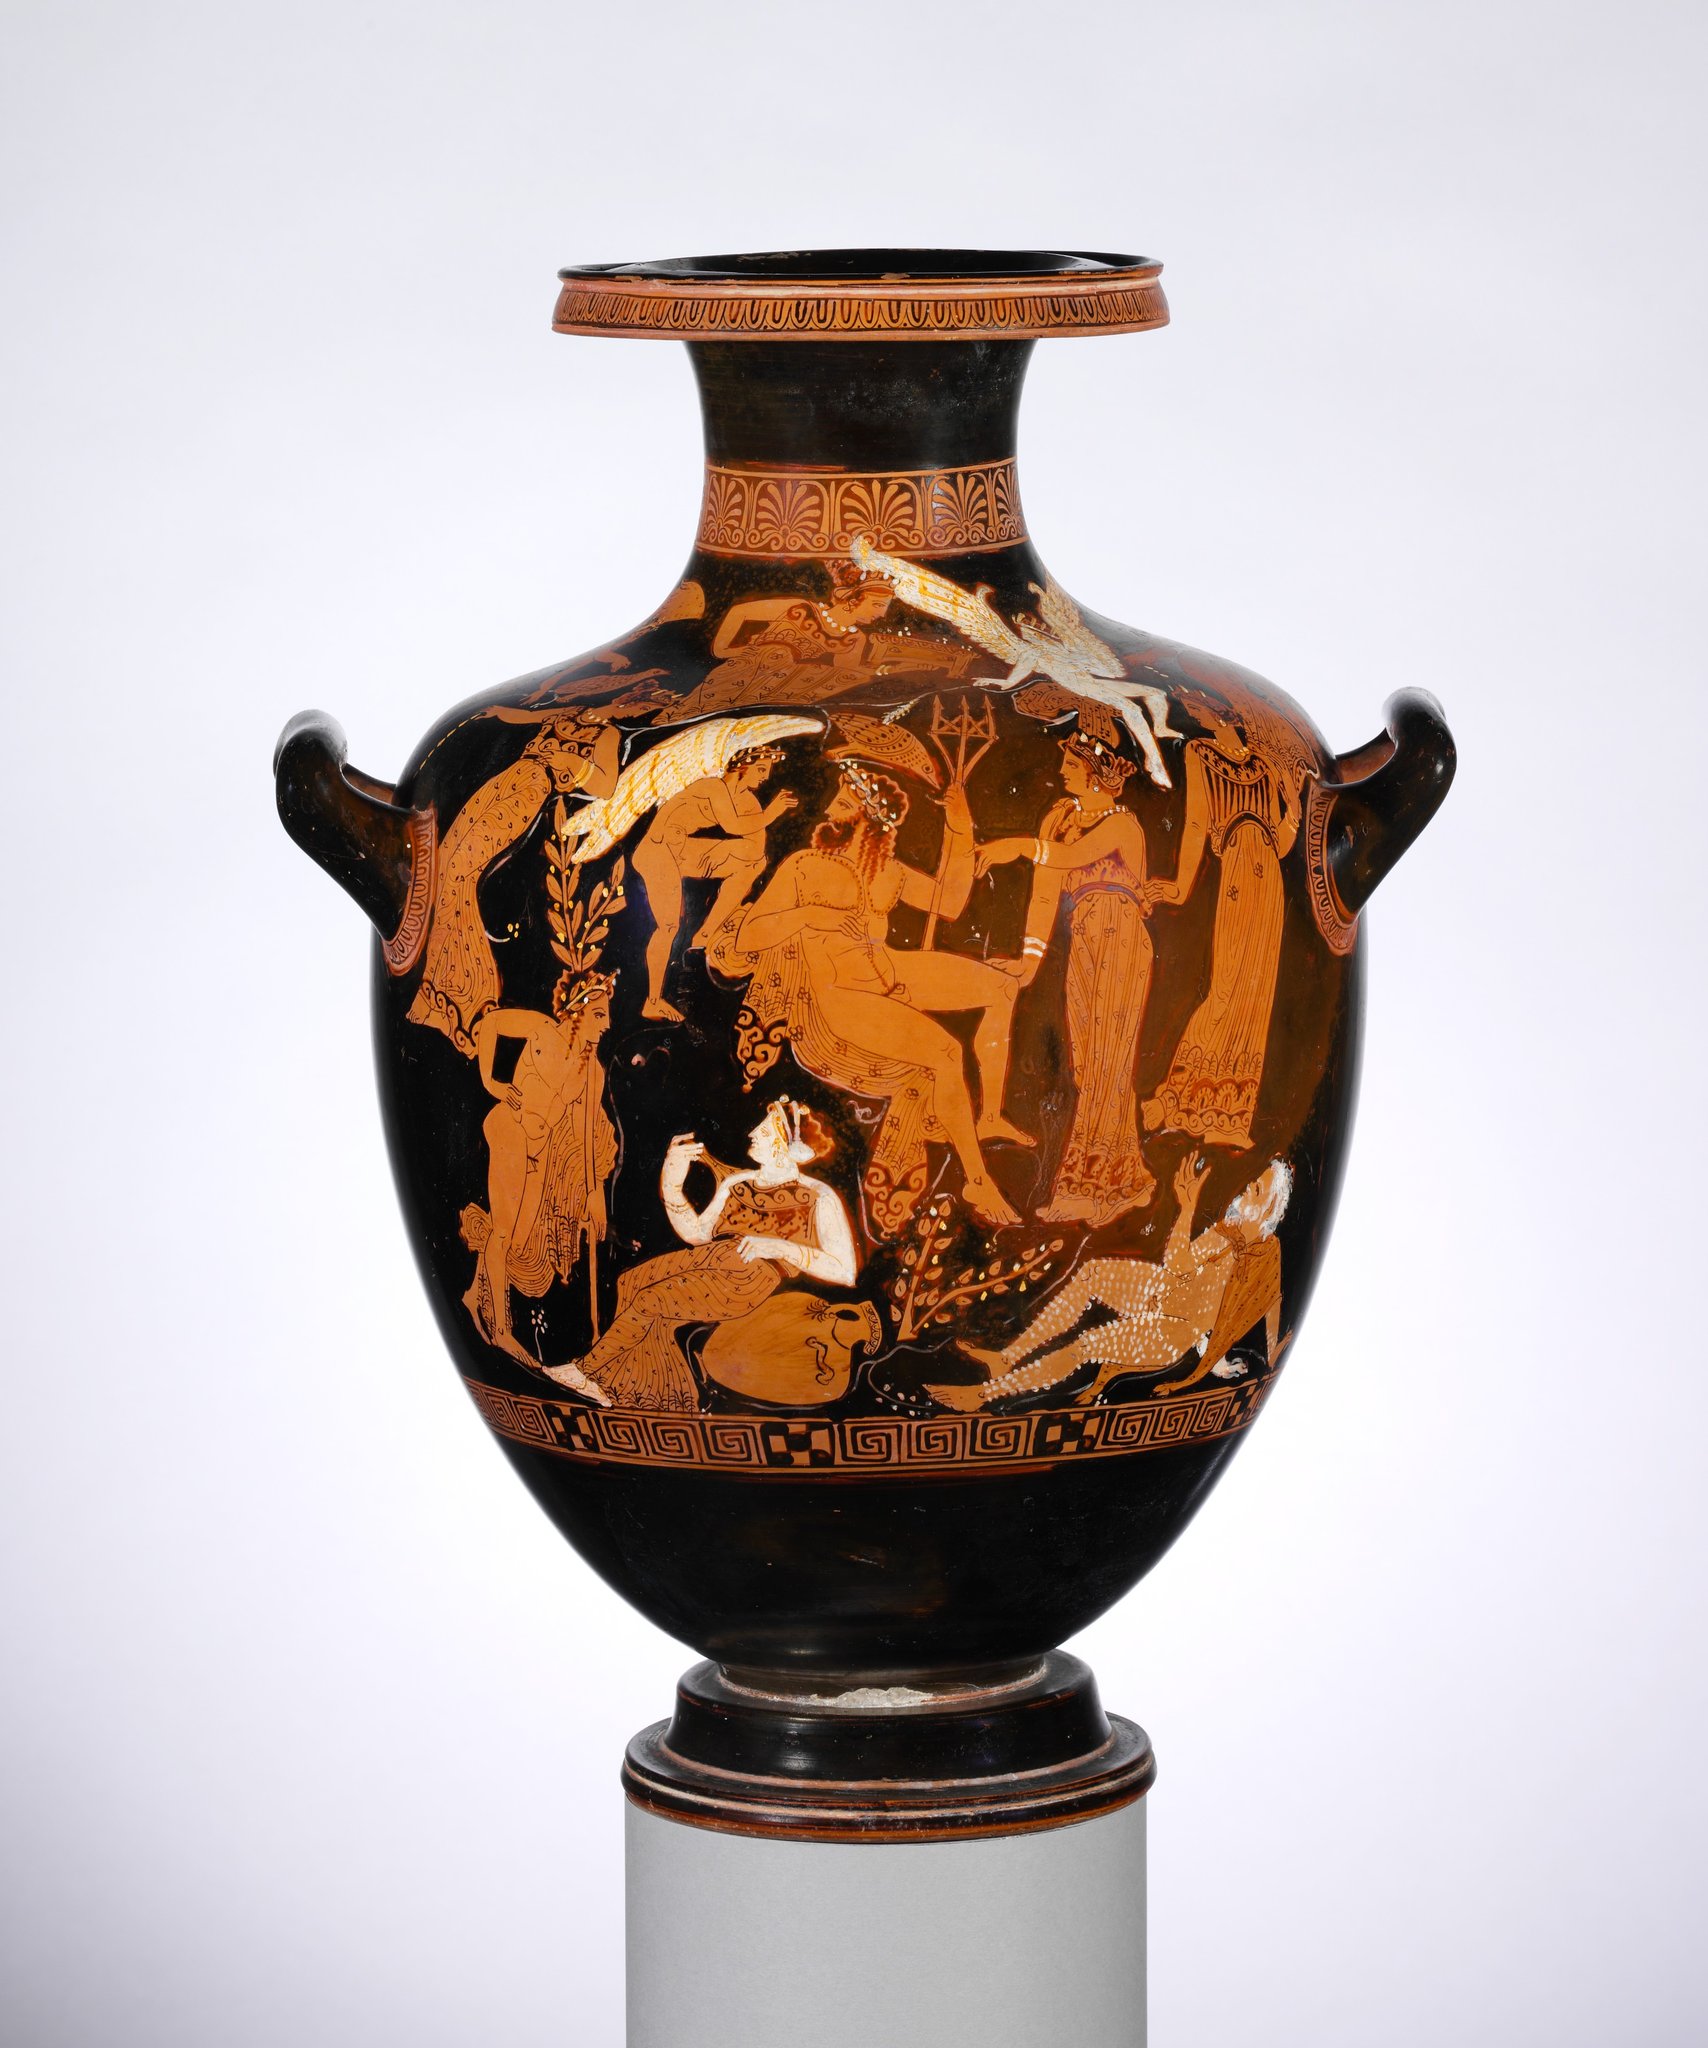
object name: hydria, kalpis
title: Terracotta hydria: kalpis (water jar)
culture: greek, attic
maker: erbach painter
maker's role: artist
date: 400-368 BCE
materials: terracotta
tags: apollo,dionysus,eros,poseidon